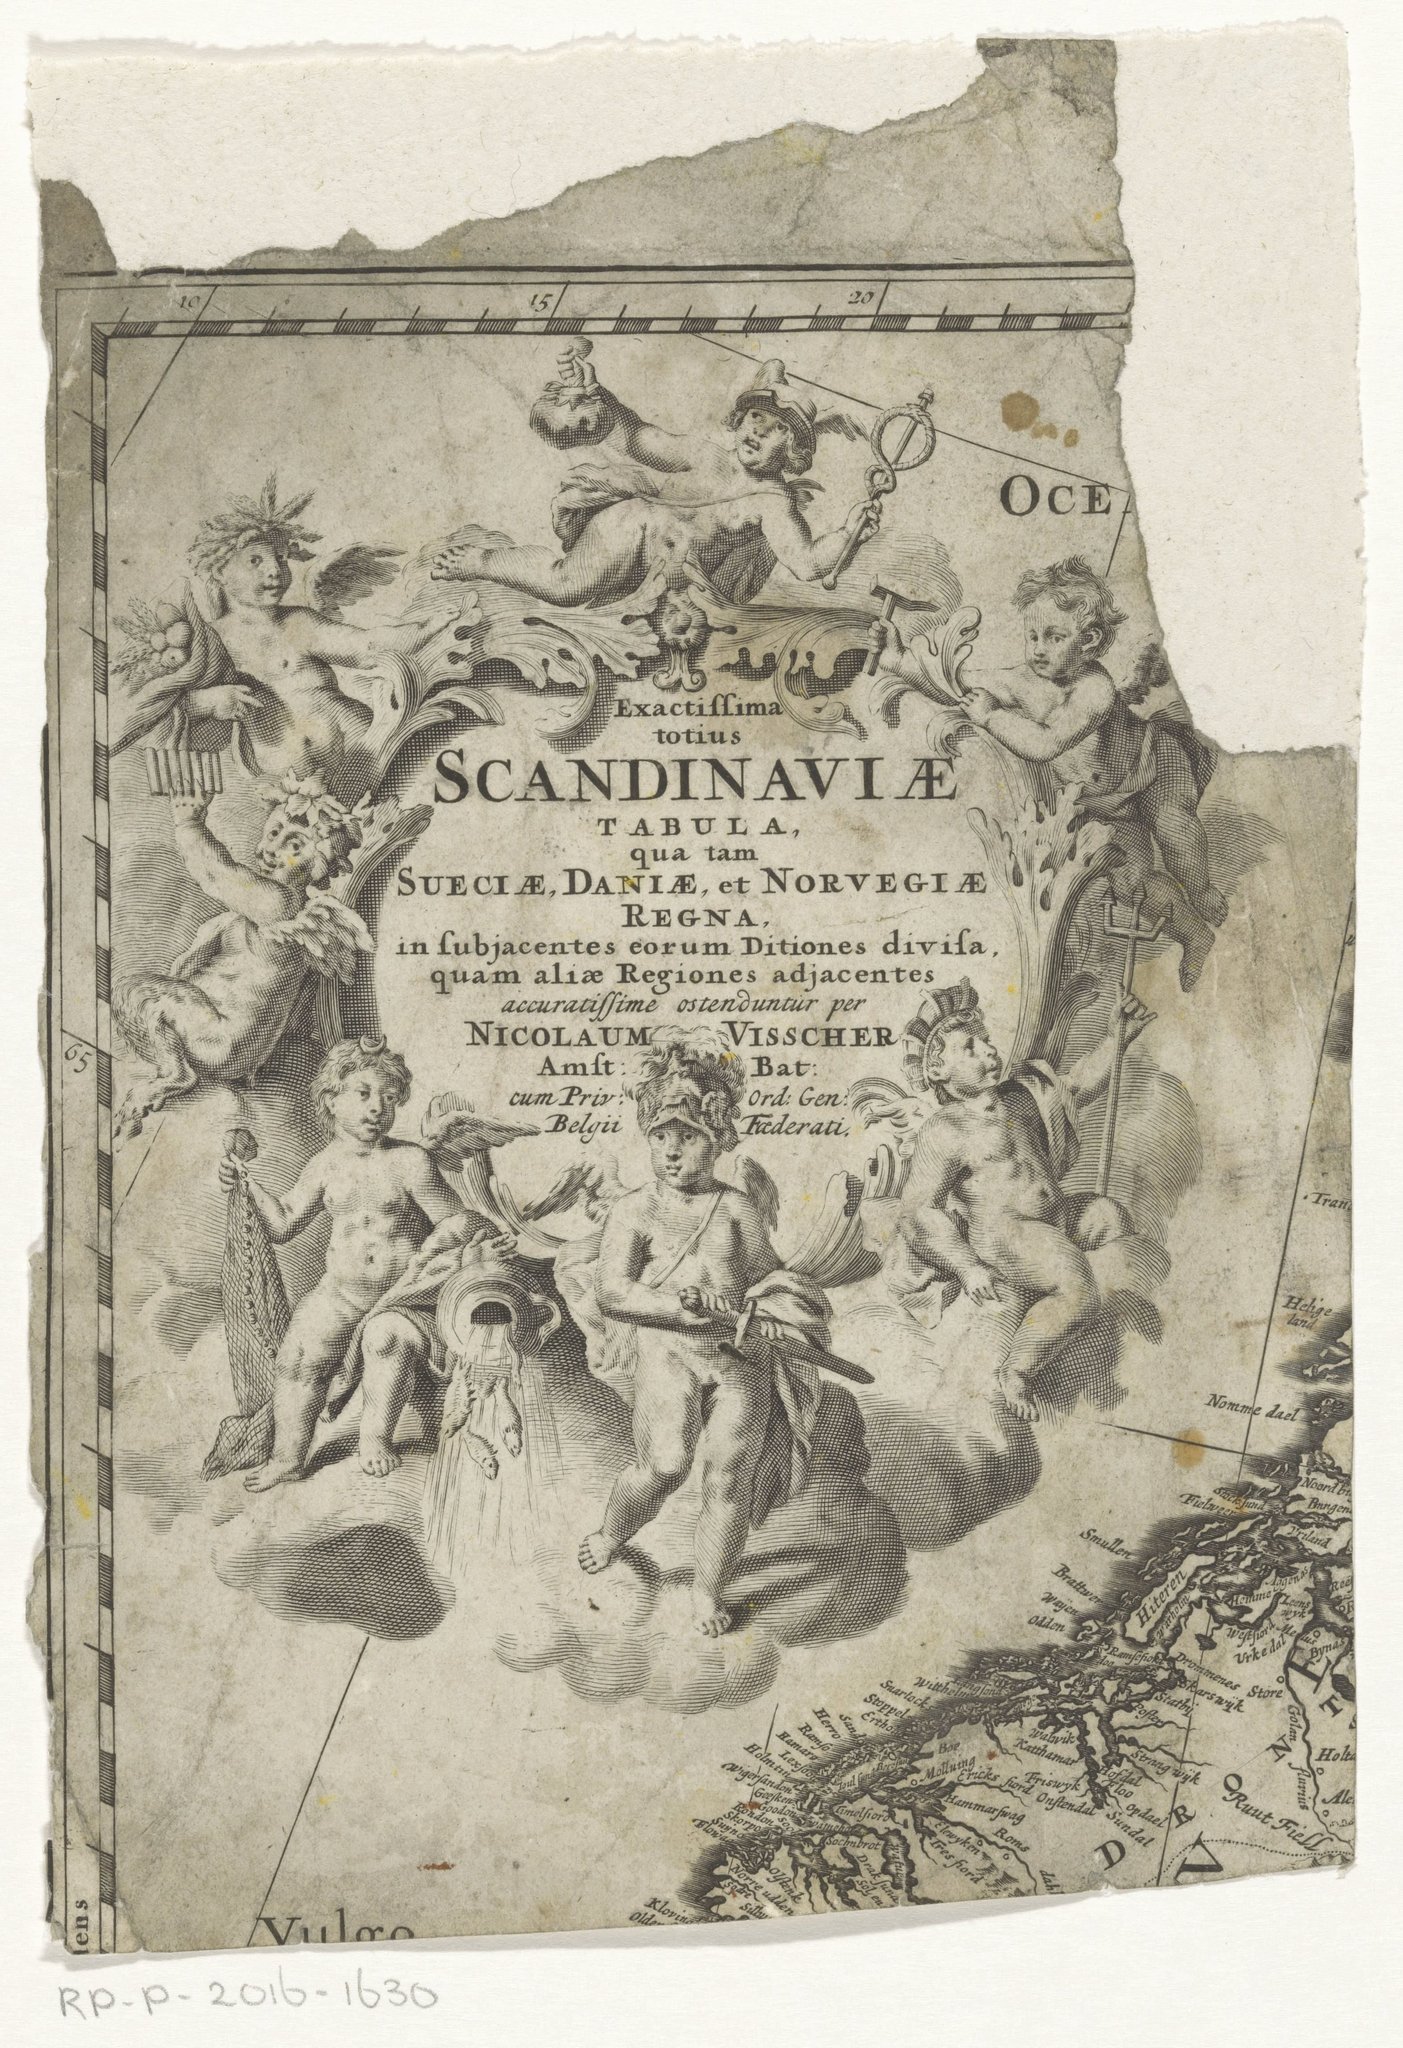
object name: print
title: Exactissima totius Scandinaviae tabula, qua tam Sueciae, Daniae, et Norvegiae Tegna (...)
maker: Anonymous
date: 1677-1702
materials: paper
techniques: engraving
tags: ornament ~ cartouche, cupids: 'amores', 'amoretti', 'putti', roman deities, and foreign deities included in the classical pantheon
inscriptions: collector's mark: Lugt 2228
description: Zeven putti met attributen van diverse goden zoals Mercurius, Ceres, Diana en Neptunus rondom een cartouche met titel. Detail van een kaart van Scandinavië.